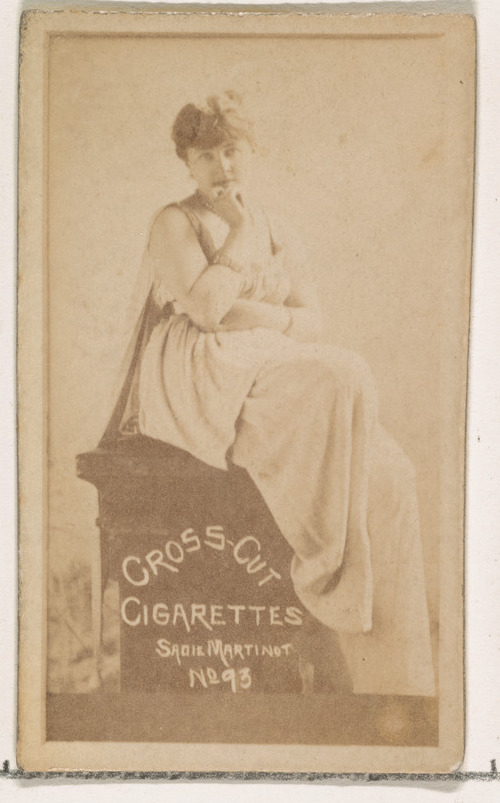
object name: print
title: Card Number 93, Sadie Martinot, from the Actors and Actresses series (N145-1) issued by Duke Sons & Co. to promote Cross Cut Cigarettes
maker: w. duke, sons & co.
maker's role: publisher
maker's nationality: american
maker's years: 1870-1920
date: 1880-1889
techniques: albumen silver print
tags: portraits,women,actresses